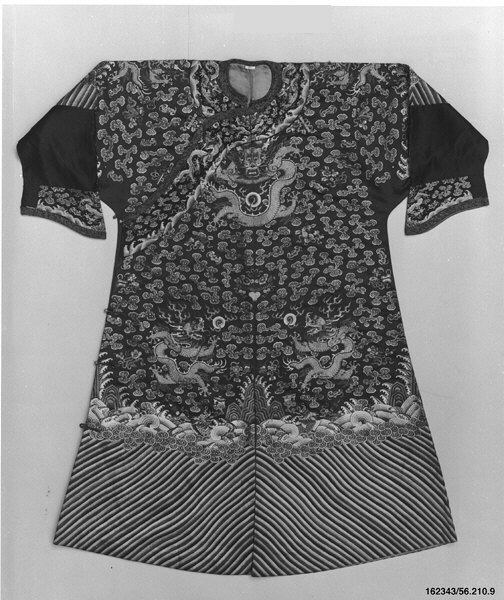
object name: robe, imperial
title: Imperial Robe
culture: chinese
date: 1767-1833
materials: silk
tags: dragons